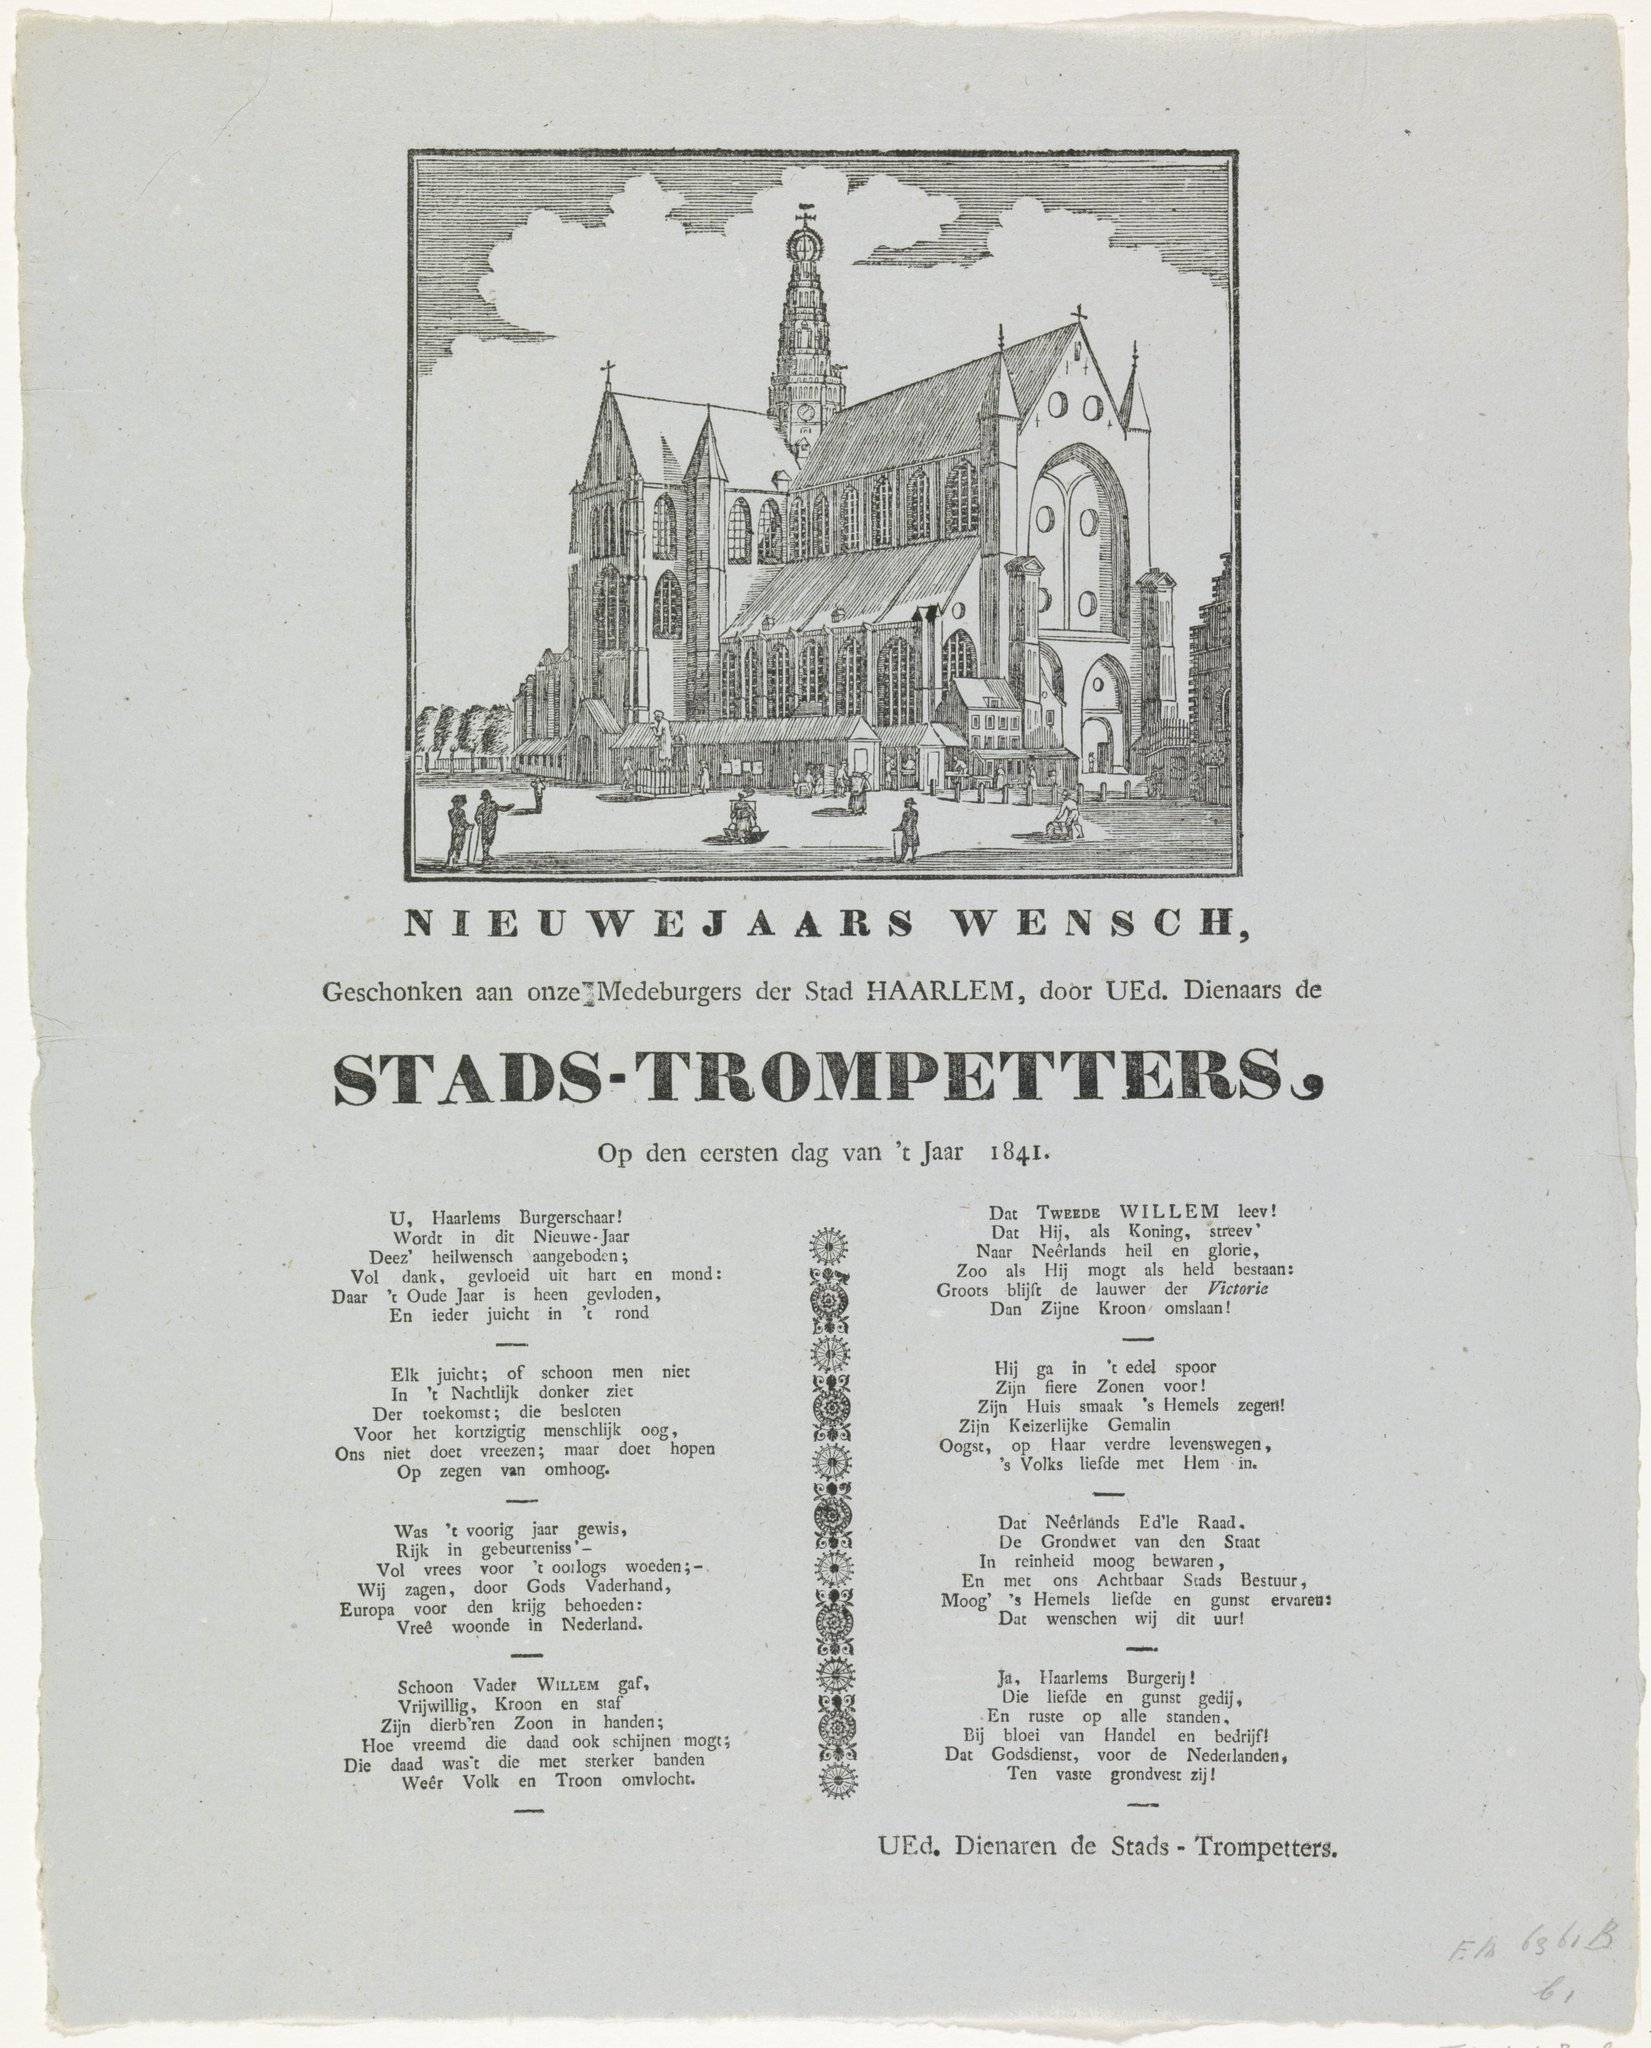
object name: new year card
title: Nieuwjaars Wensch (...) door UEd. Dienaars de Stads-Trompetters (...) 1841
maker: Anonymous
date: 1840-1841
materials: paper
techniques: letterpress printing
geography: haarlem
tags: tower sentry, church (exterior), street, haarlem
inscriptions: collector's mark: Lugt 2228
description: Nieuwjaarswens van de Haarlemse torenwachters (stadstrompetters) voor het jaar 1841. Gezicht op de Grote Markte te Haarlem met een torenwacht op de toren van de Sint-Bavo. Met een vers in twee kolommen.